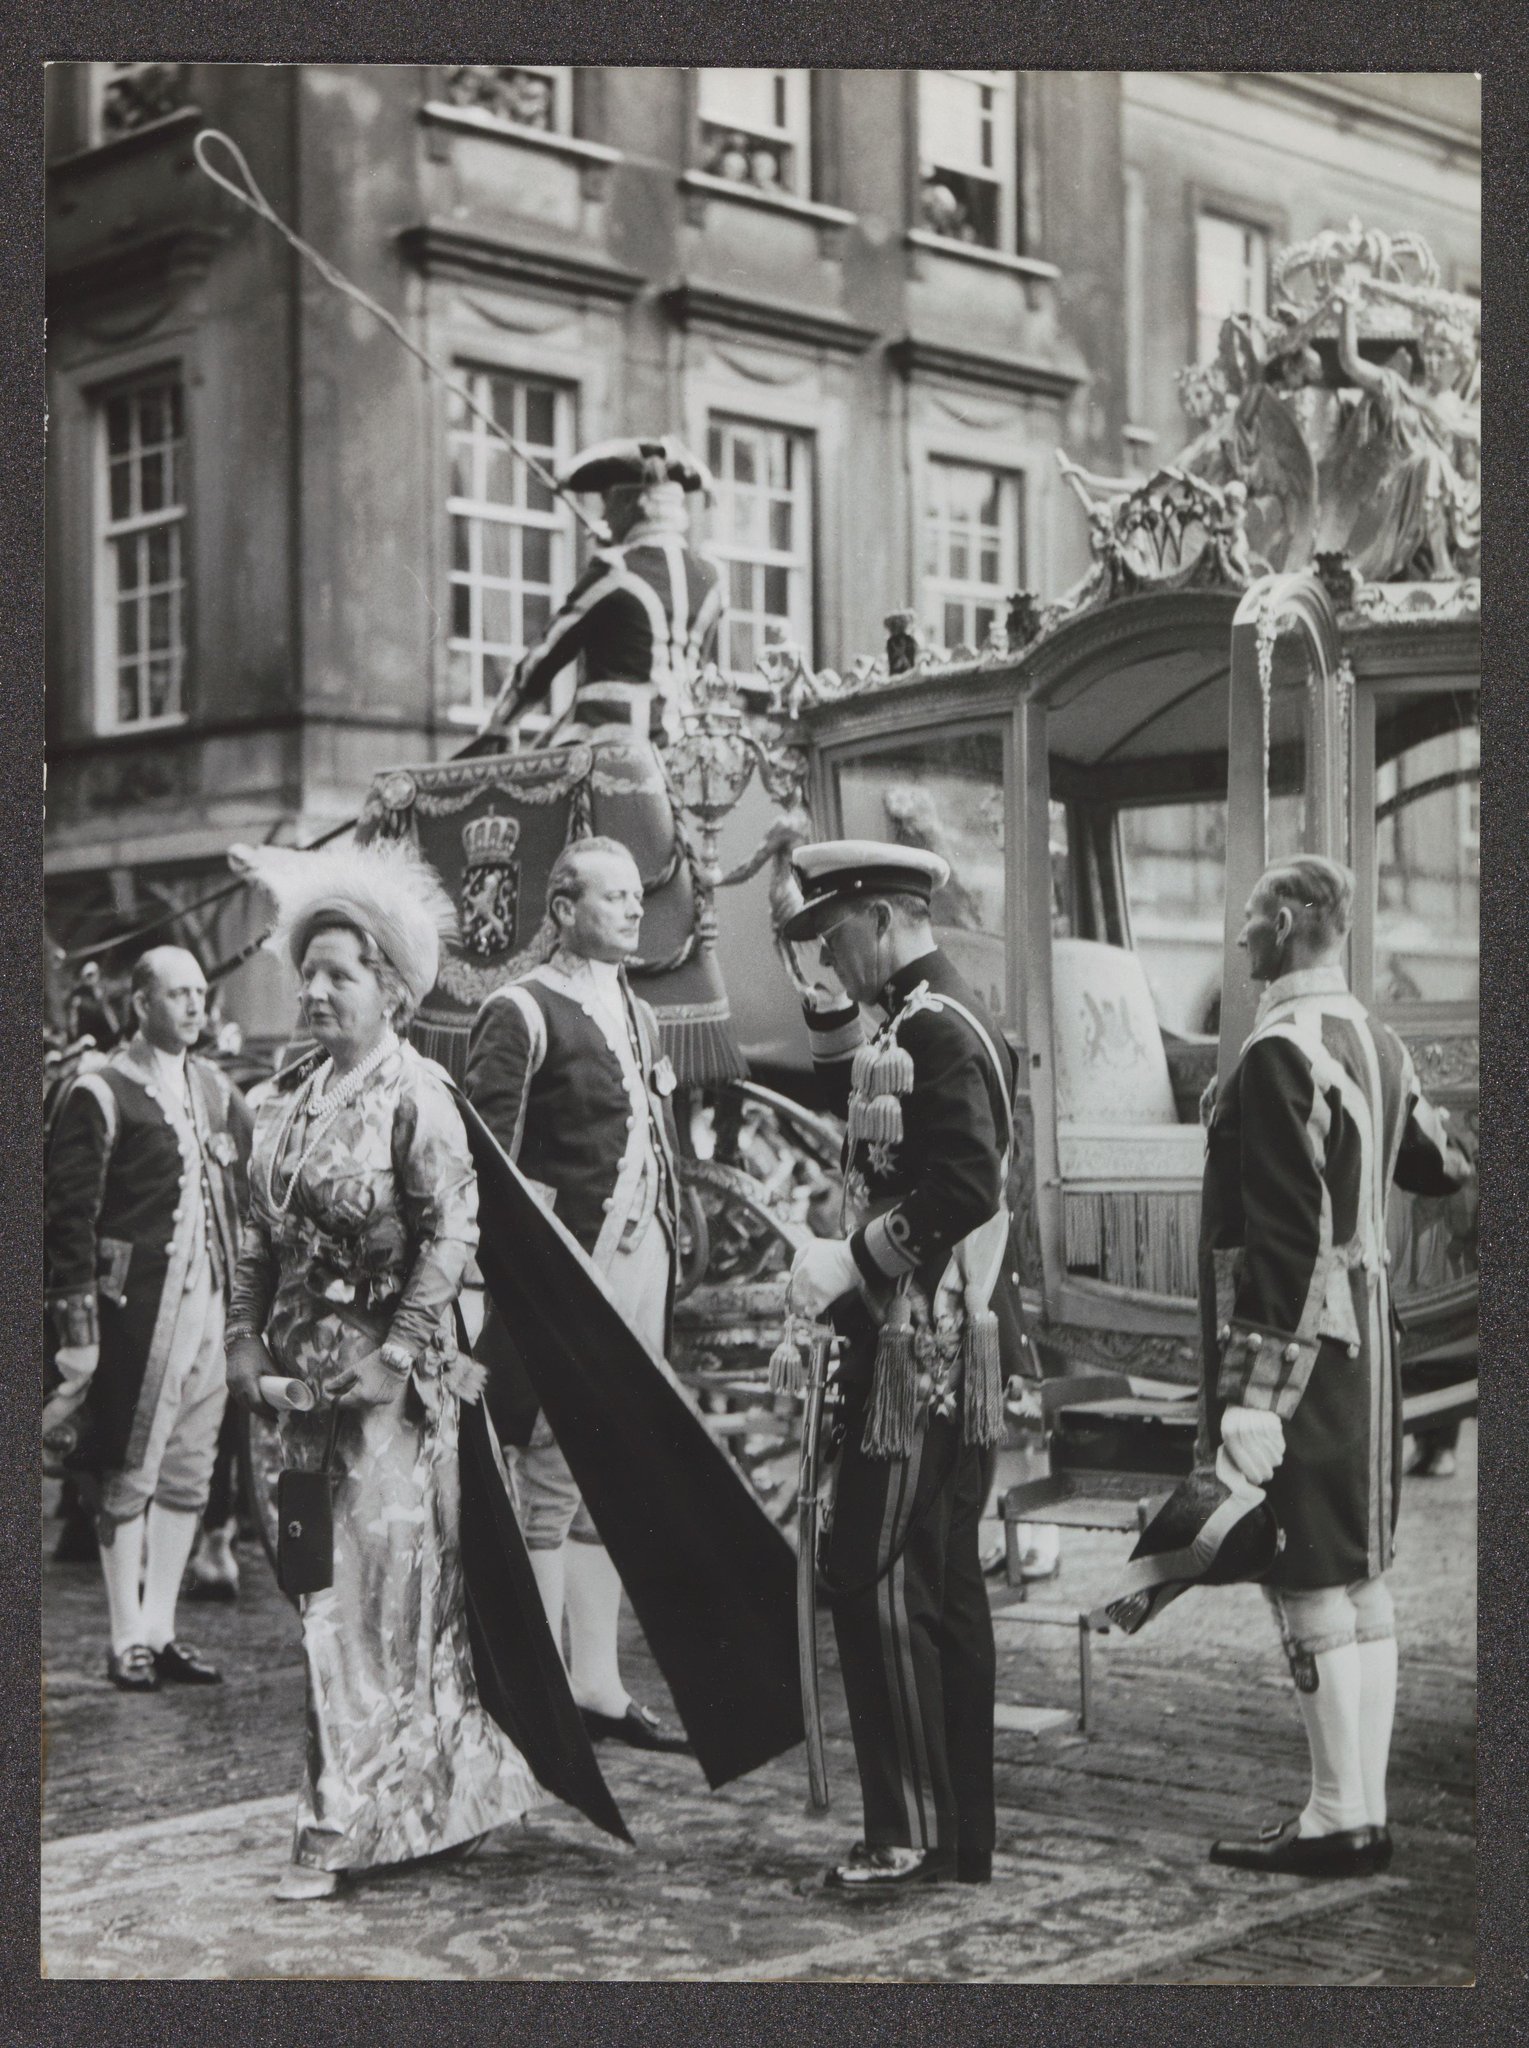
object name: photograph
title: Aankomst van koningin Juliana en prins Bernhard op het Binnenhof, Den Haag, voor de opening van de Staten-Generaal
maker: joop van bilsen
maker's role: fotograaf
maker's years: 1905-1977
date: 1962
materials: paper, photographic support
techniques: gelatin silver print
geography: netherlands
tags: the hague, juliana of the netherlands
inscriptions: annotation: ‘Opening of the Parliament. / To-day H.M.Queen Juliana opened the first meeting / after the recess of the States-General in the Ridder- / zaal of the Parliament-Building at The Hague. / Photo:Queen Juliana leaving the Golden Coach at the / Binnenhof before the Parliament-Building. / FOTO-ANEFO 18-9-1962 / (Foto Van Bilsen)’